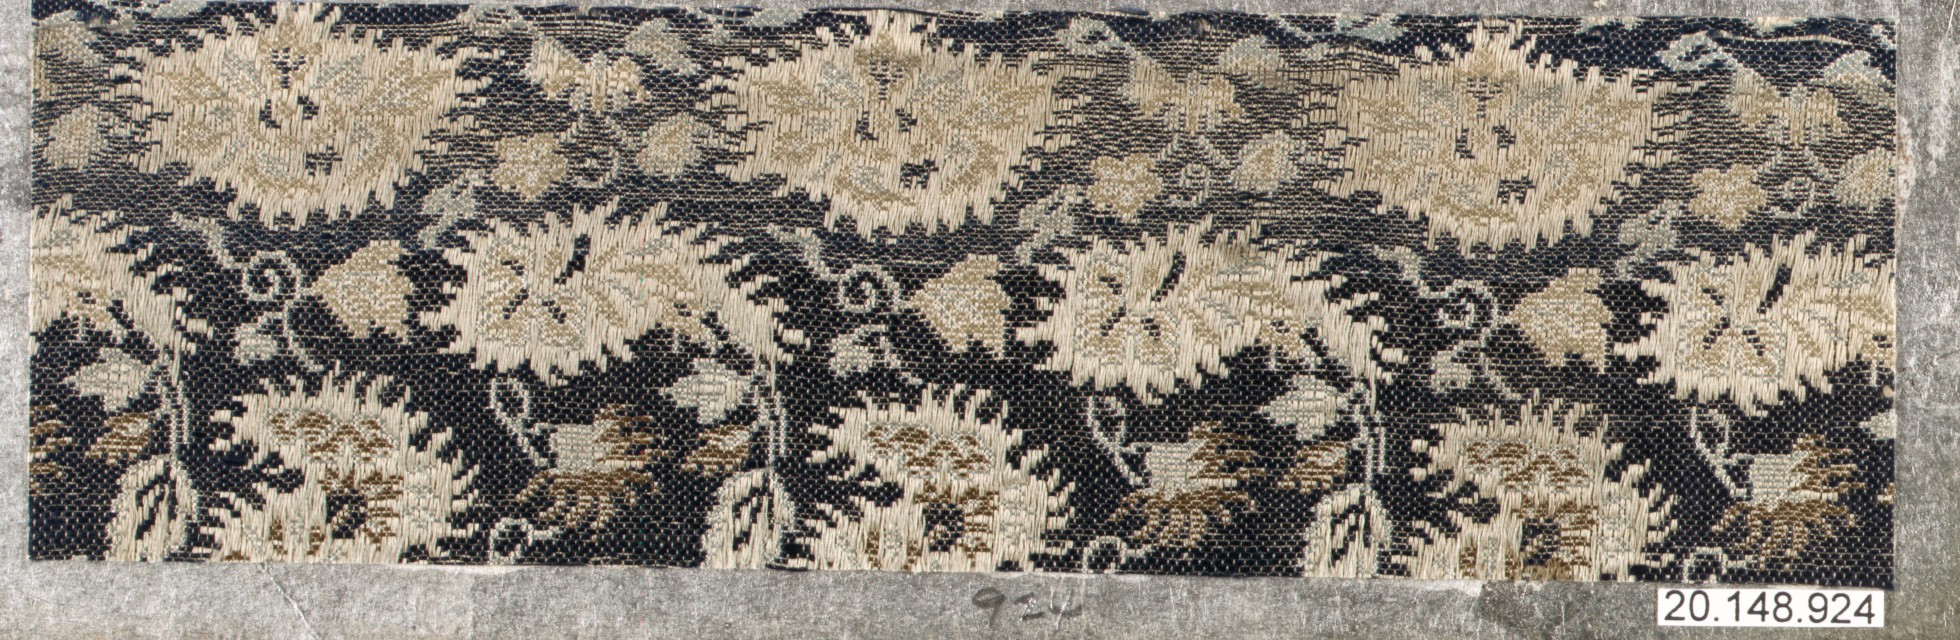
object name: piece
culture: chinese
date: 1701-1800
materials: silk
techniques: compound weave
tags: flowers